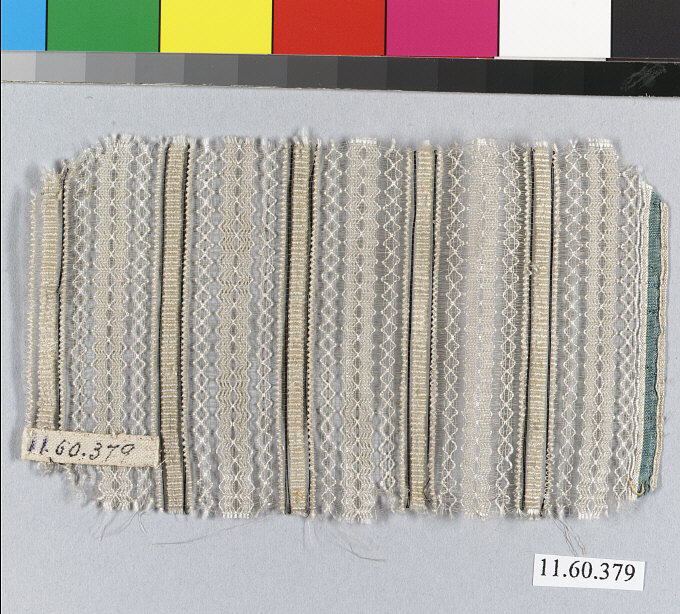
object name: fragment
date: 1801-1900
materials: silk